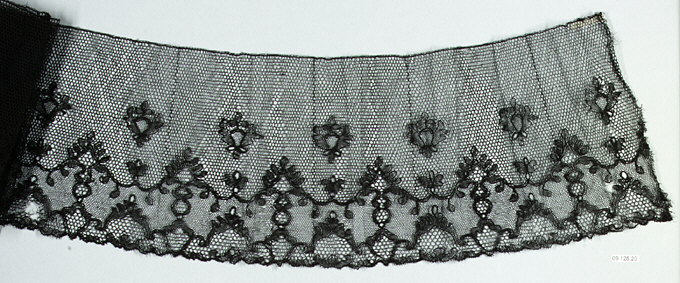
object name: piece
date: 1801-1900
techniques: lace